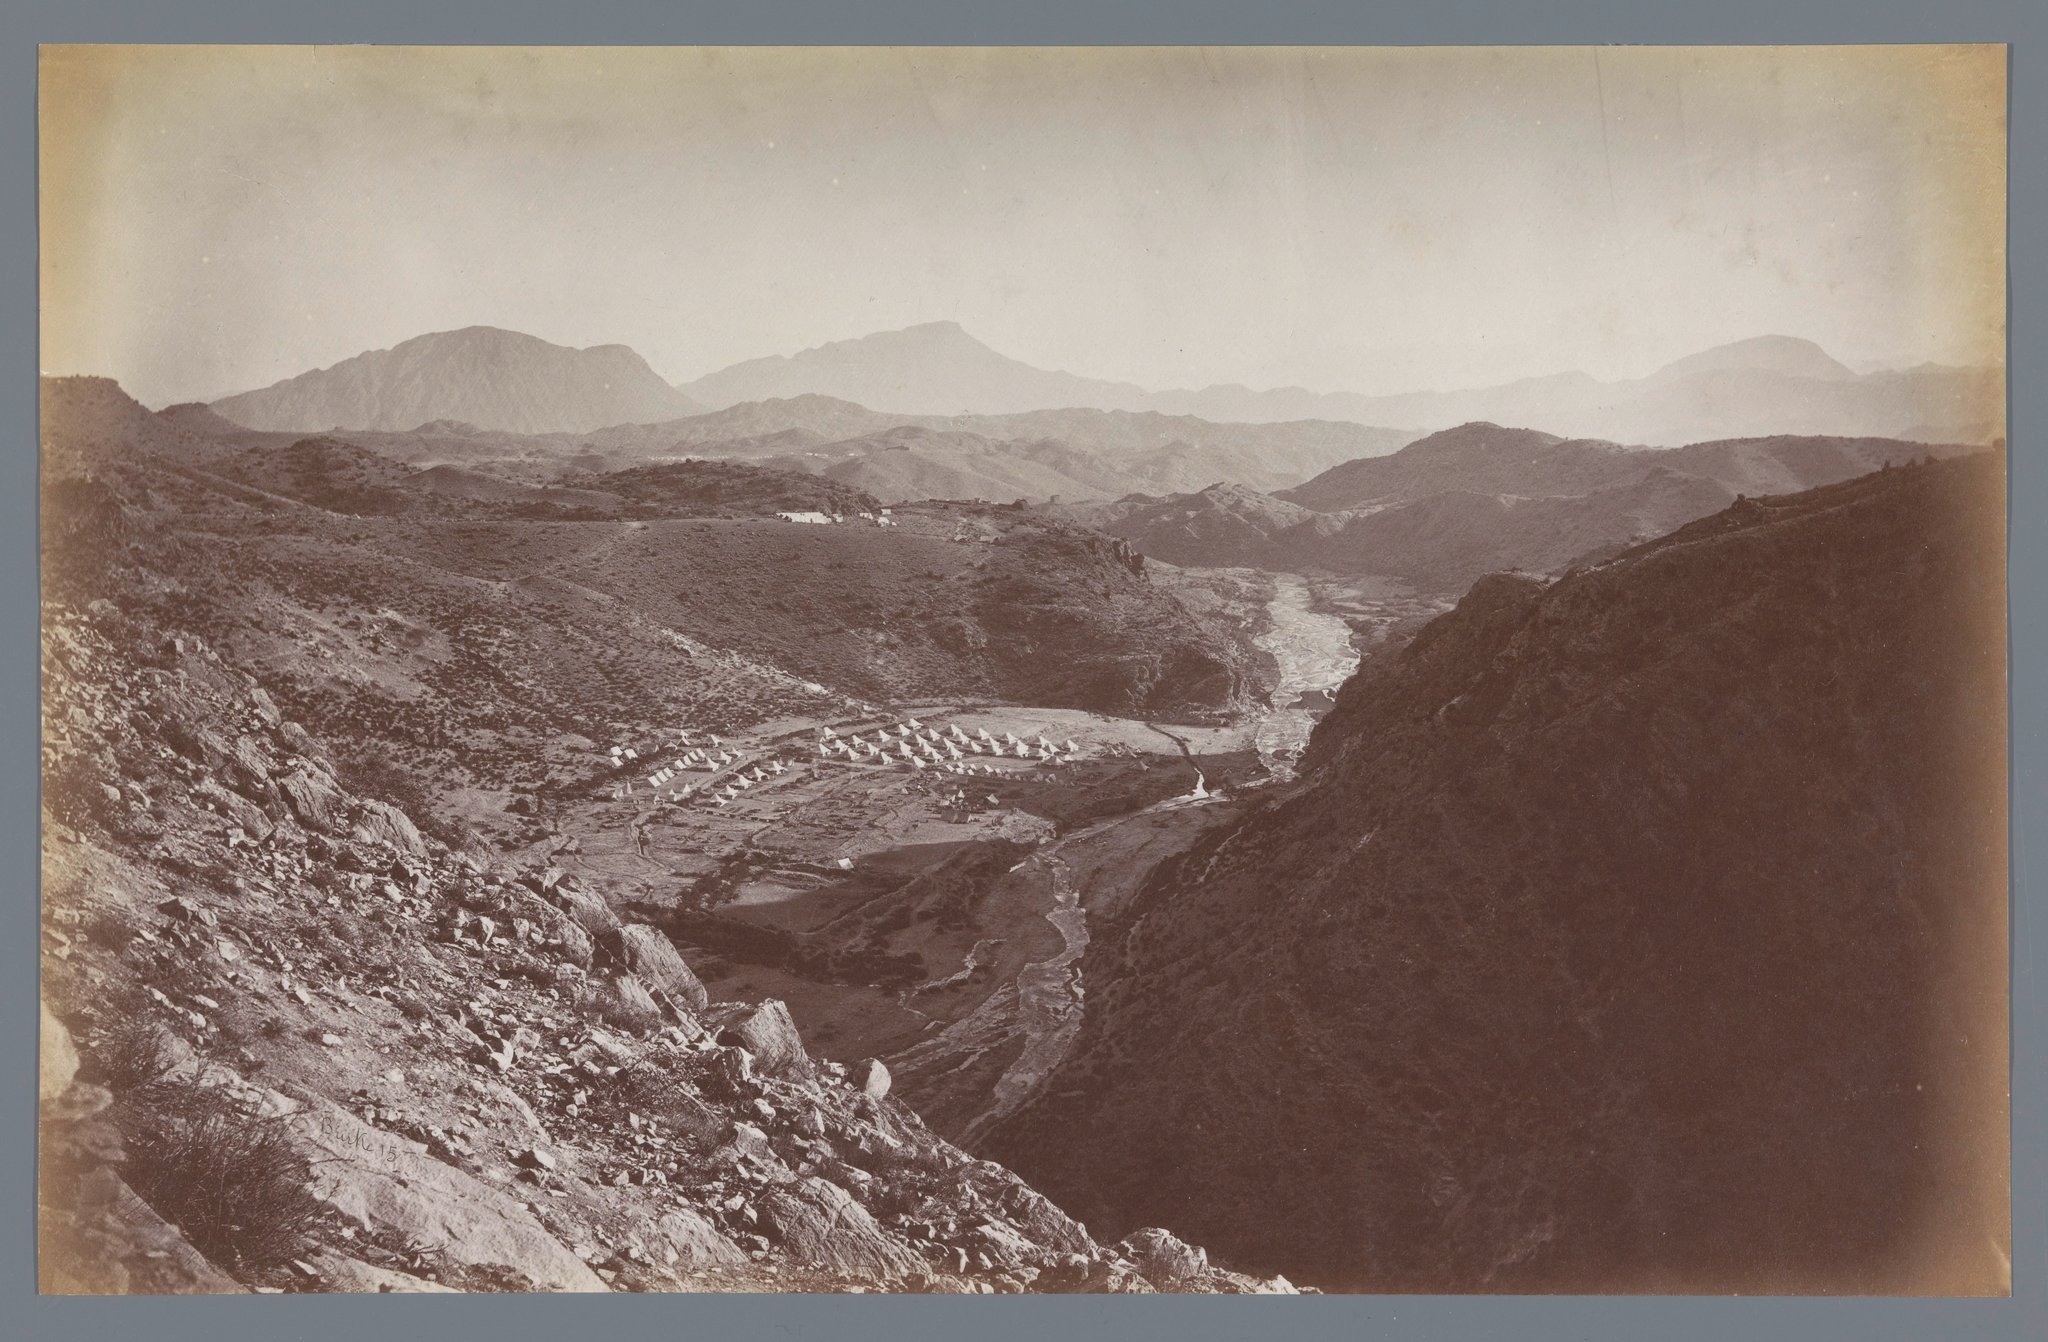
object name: photograph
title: View of military tent camps near Peshawar prior to the battle of Ali Masjid during the Second Anglo-Afghan War, Khyber Pass, Khyber Pakhtunkhwa, Pakistan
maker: j.n.o. burke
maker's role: fotograaf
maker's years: 1843-1900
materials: paper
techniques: albumen print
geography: khyber pass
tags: (military) camp with tents, mountains - hh - ideal landscapes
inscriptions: number: ‘15’, name: ‘Burke’, number: ‘81’